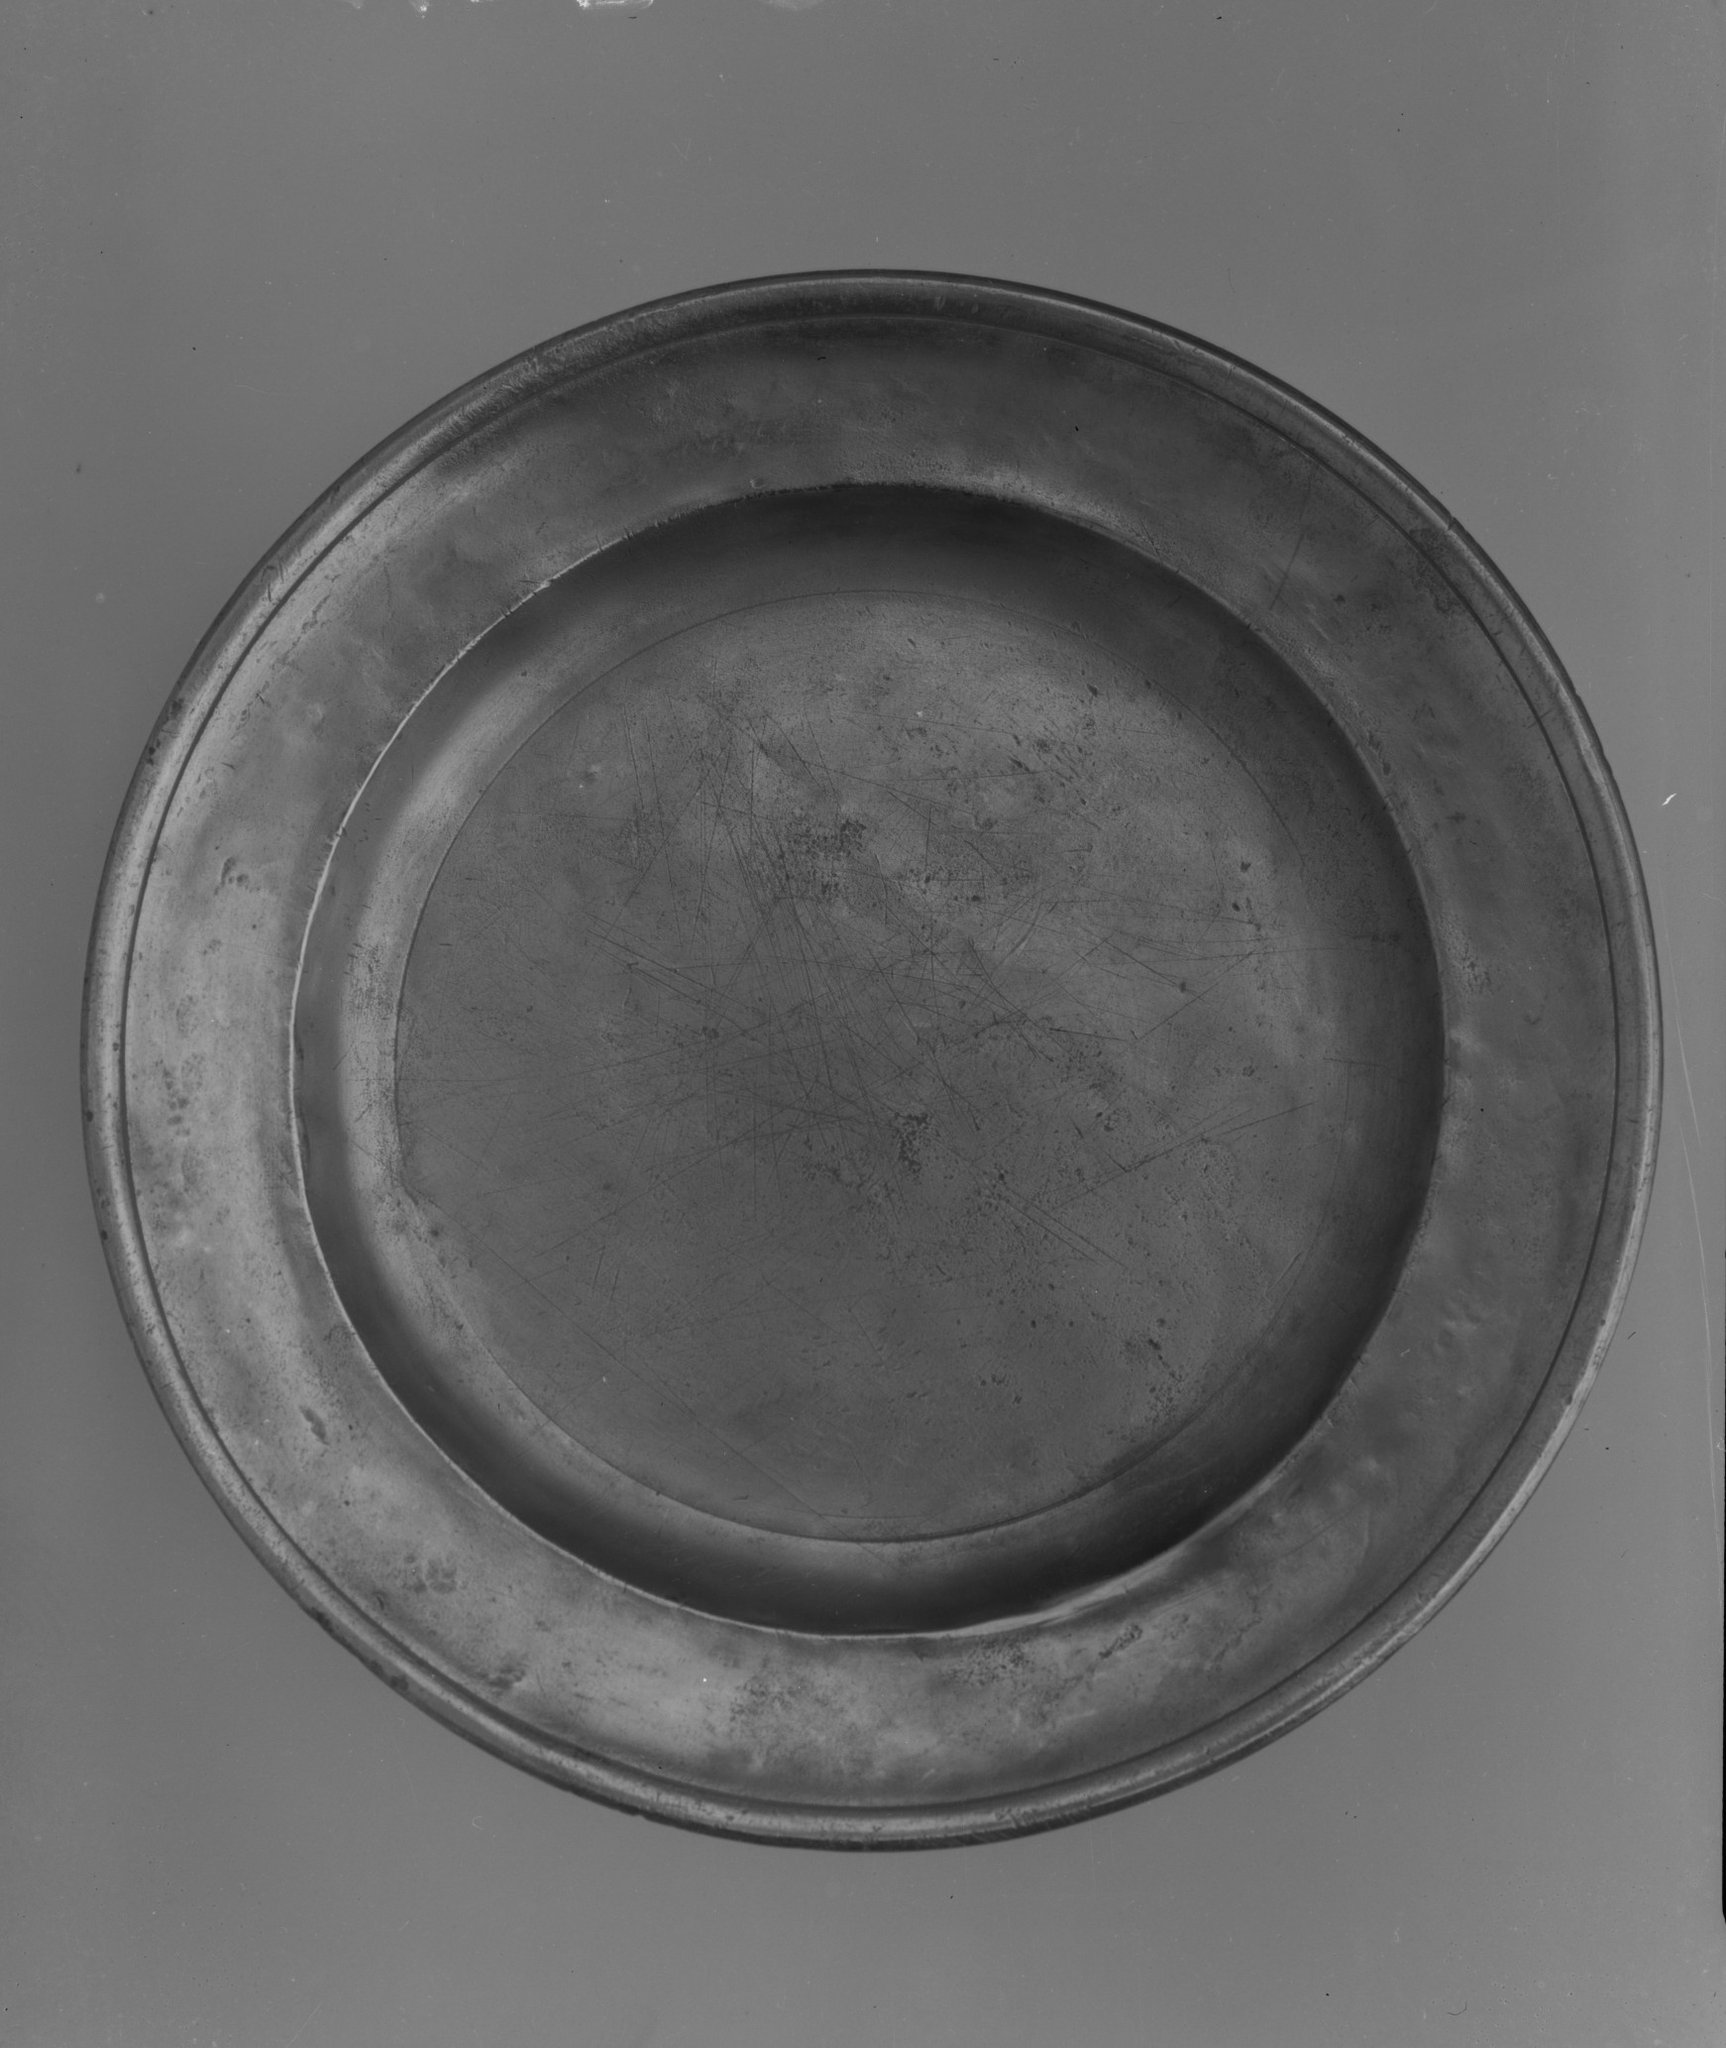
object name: plate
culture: american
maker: j. and d. hinsdale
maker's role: maker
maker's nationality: american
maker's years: 1810-1826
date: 1810-1826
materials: pewter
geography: united states